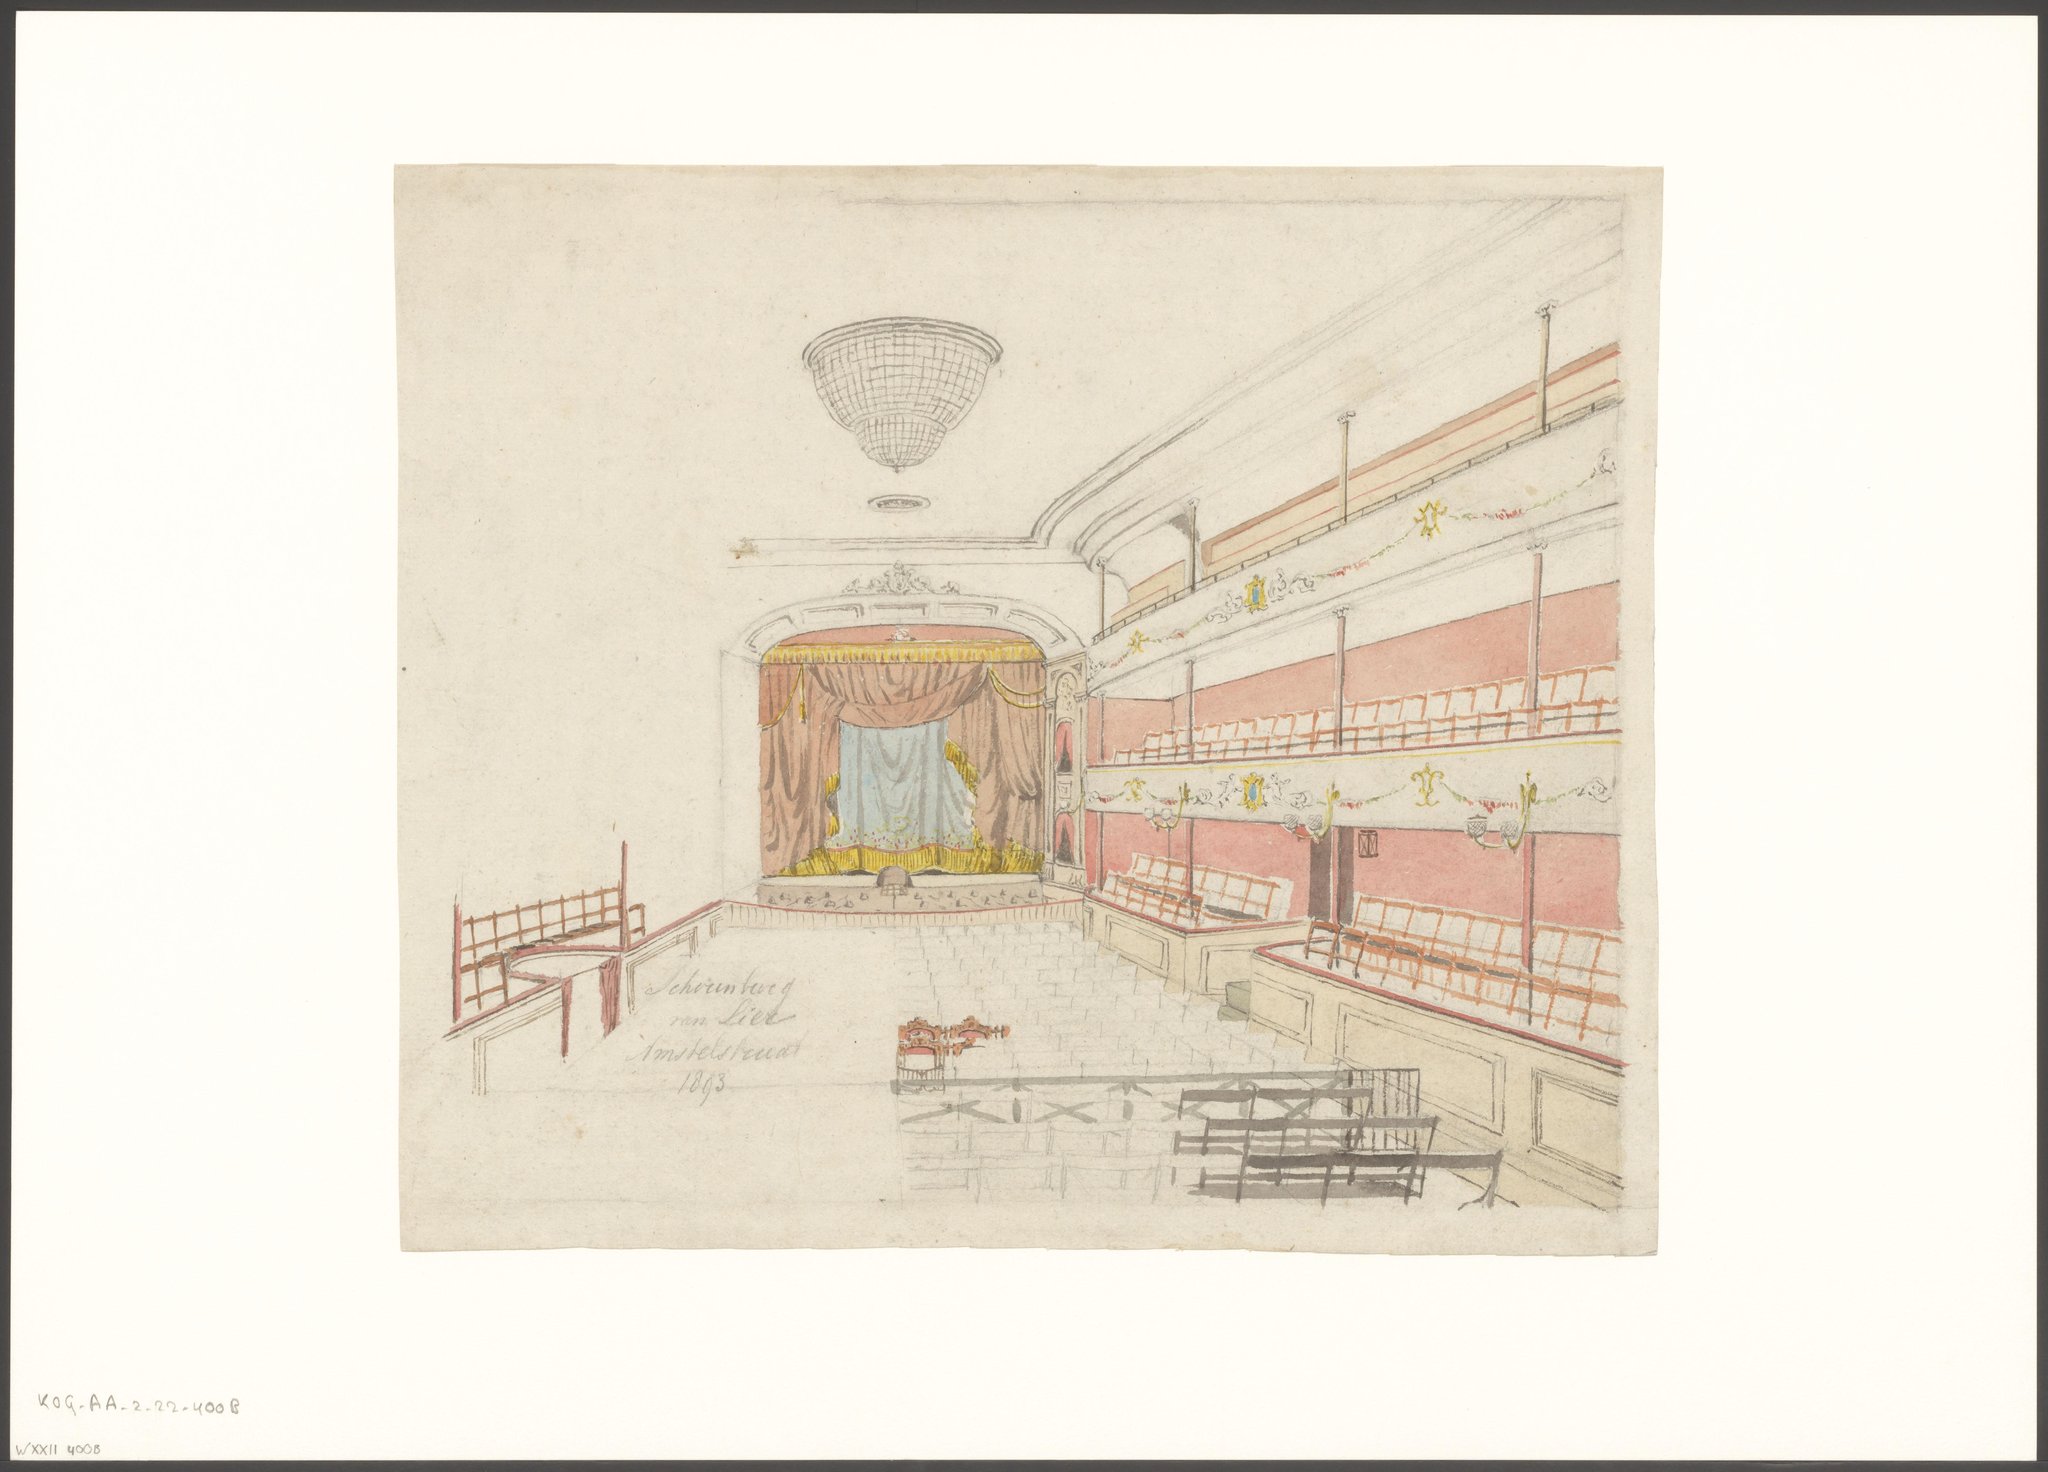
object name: drawing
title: Interieur van de Grand Théâtre des Variétés aan de Amstelstraat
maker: johan george lodewijk rieke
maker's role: draughtsman, print maker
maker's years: 1817-1898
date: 1893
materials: paper, pencil, watercolor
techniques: brush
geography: amsterdam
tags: city-view in general; 'veduta', theatre, theatrical performance, the stage and its equipment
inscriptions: inscription: ‘Schouwburg / van Lier / Amstelstraat / 1893’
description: Tekening binnen de Atlas Van Eck ingedeeld op wijknummer 22.